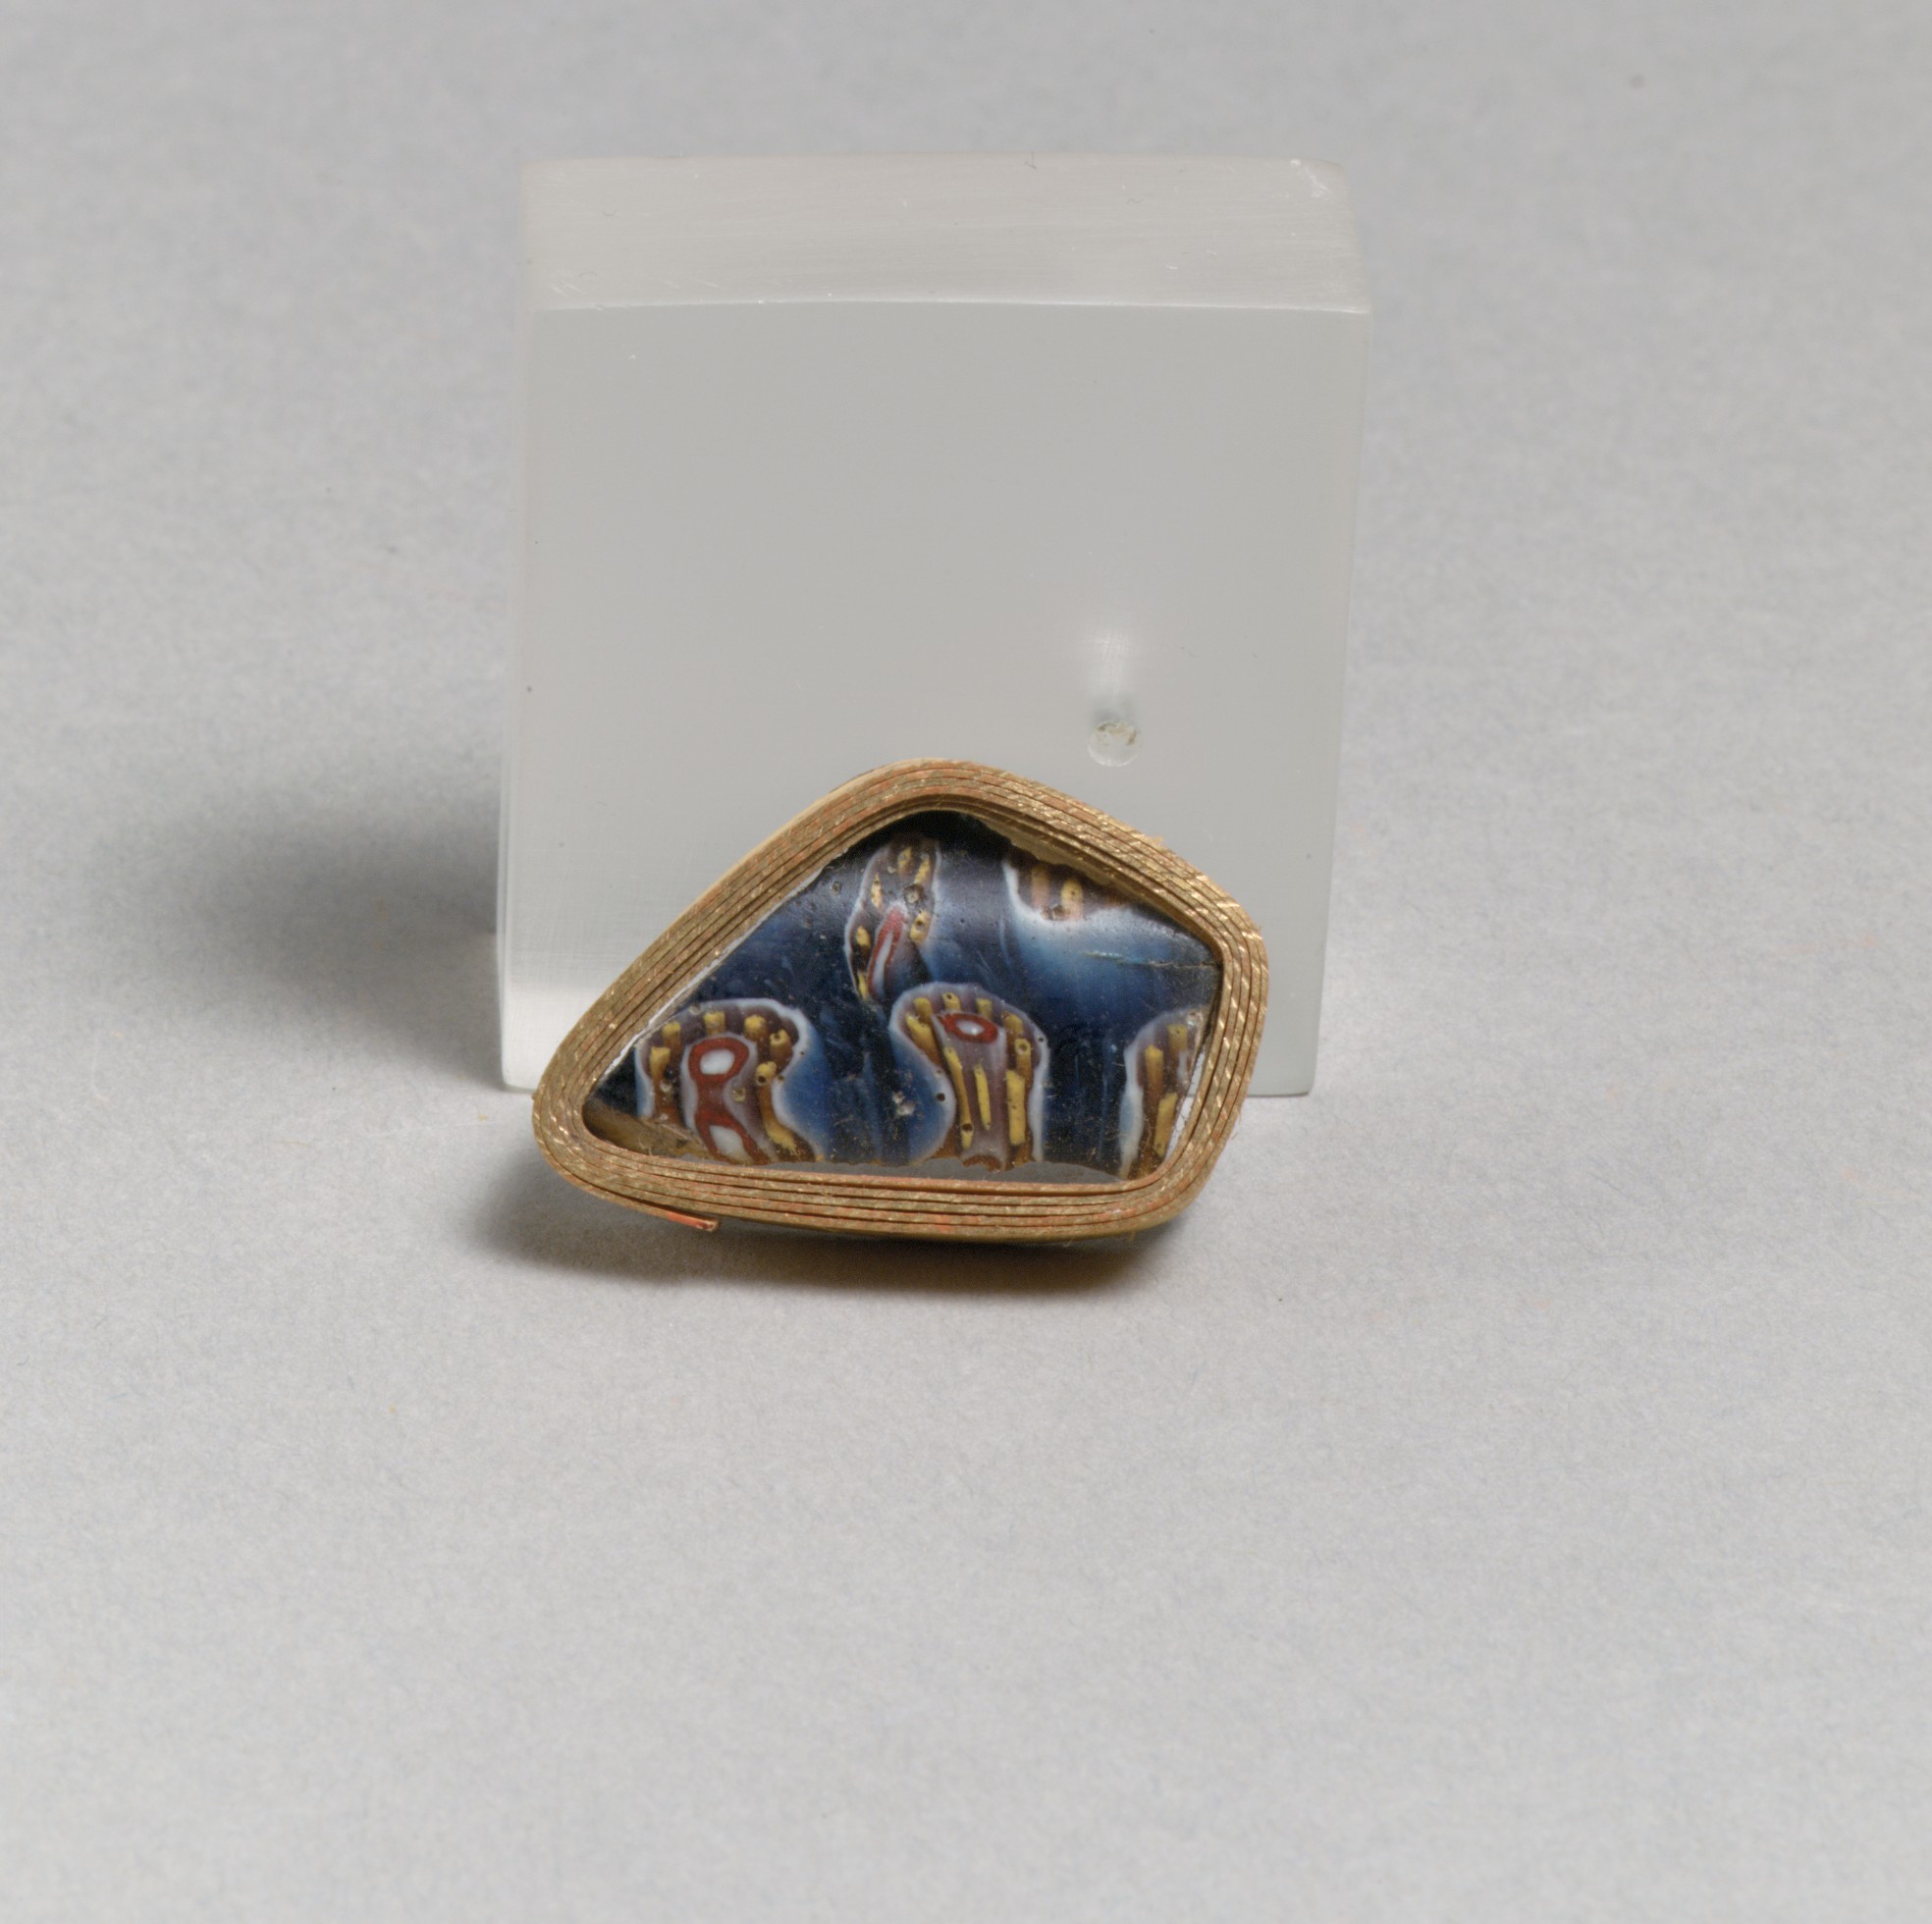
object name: fragment, mosaic bowl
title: Glass mosaic carinated bowl fragment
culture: roman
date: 34 BCE-33 CE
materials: glass